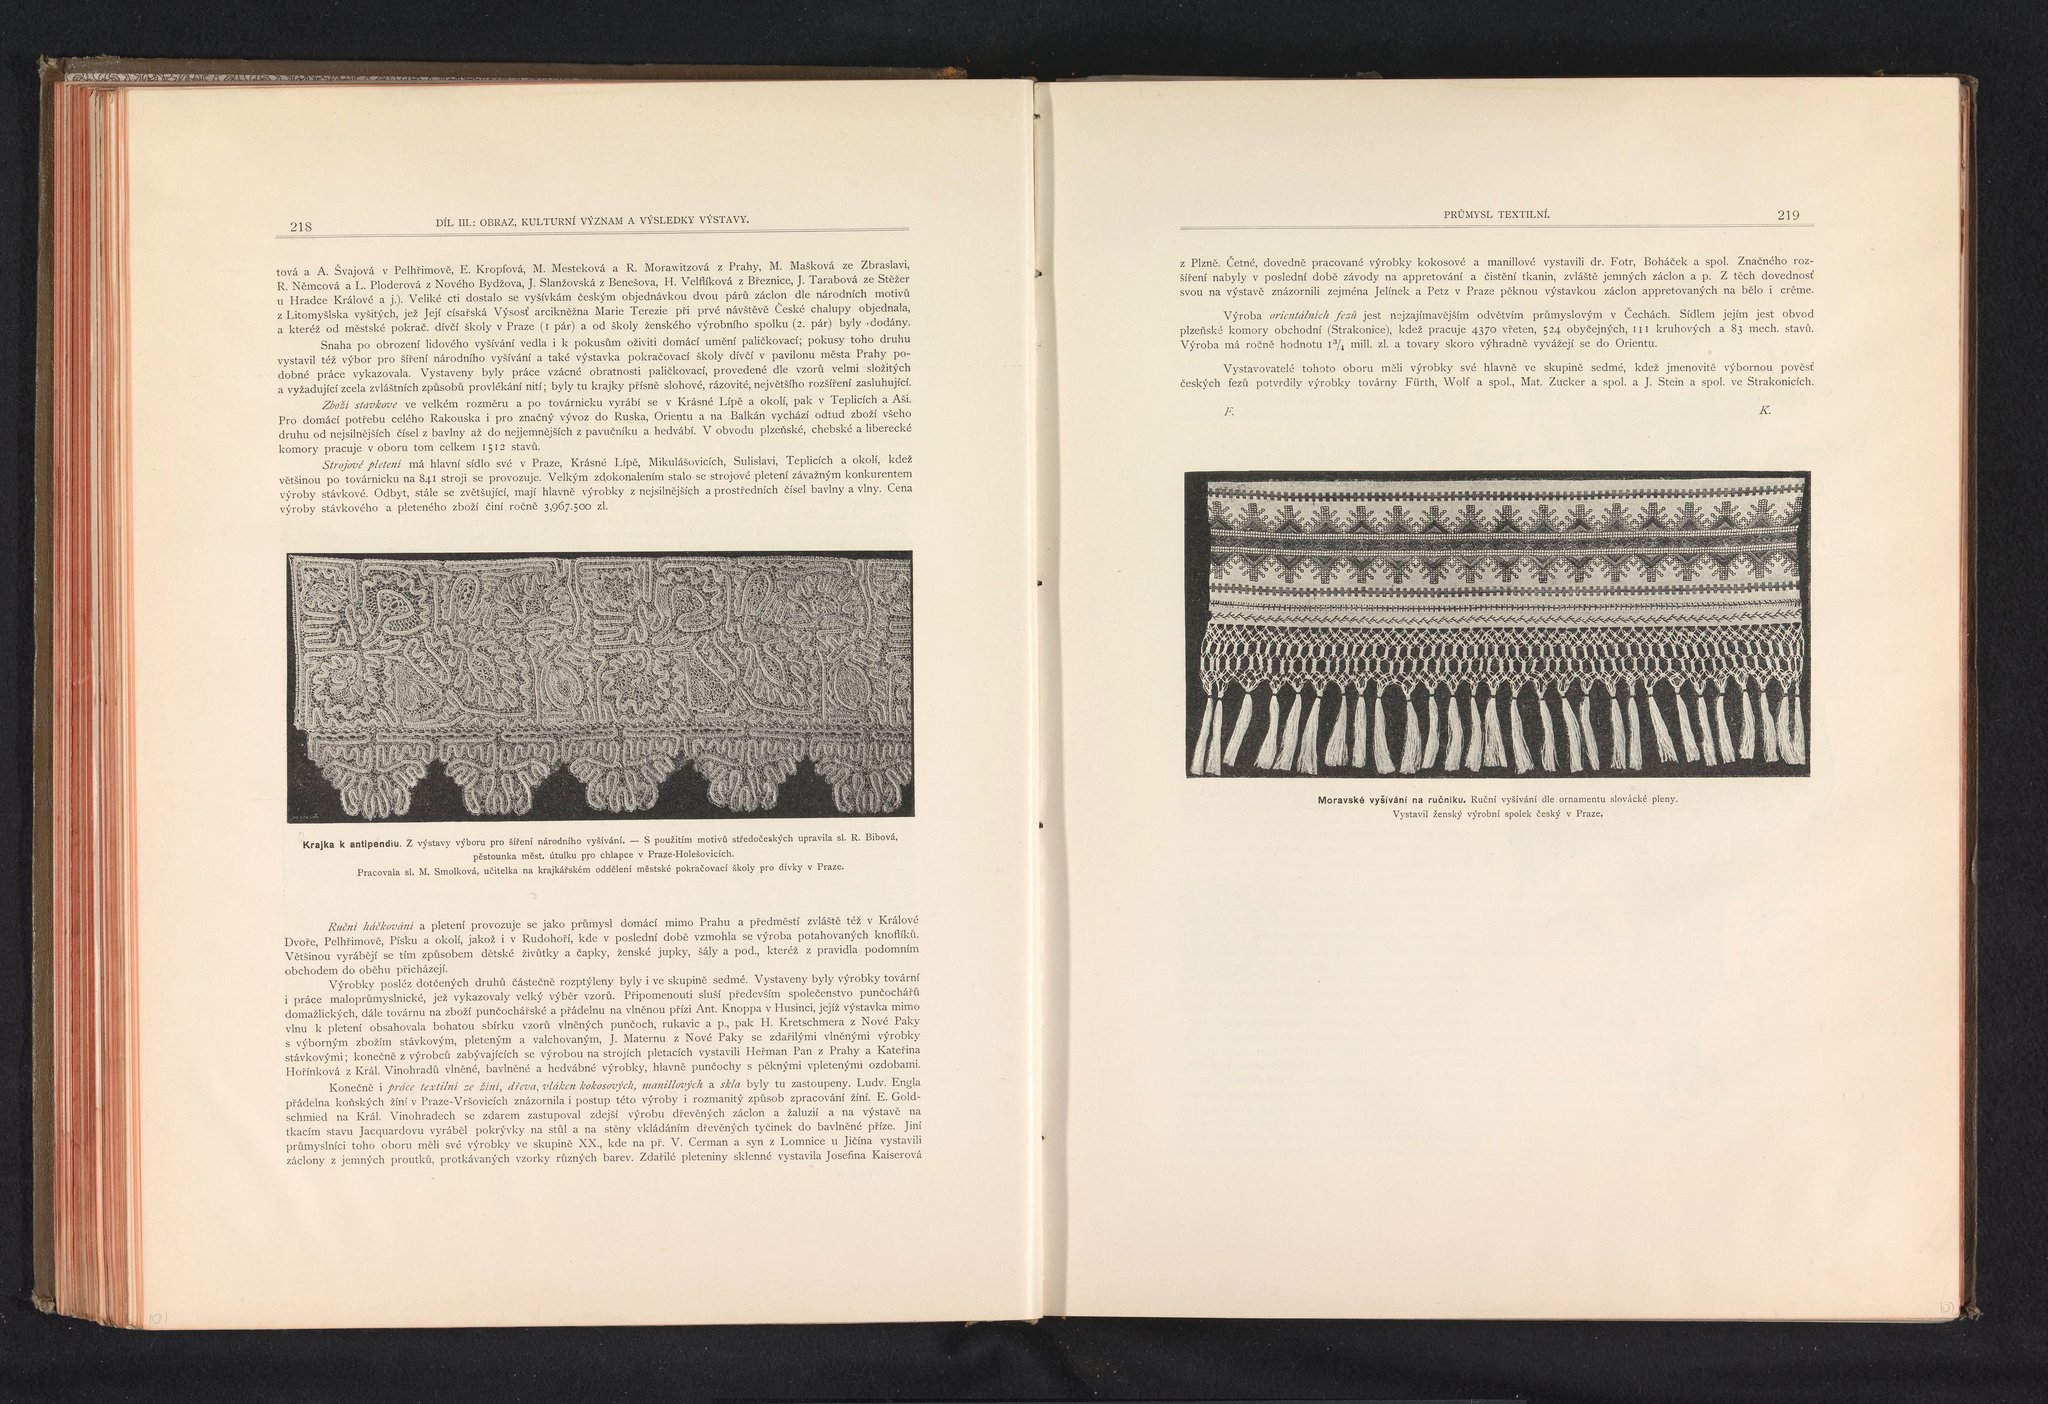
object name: photomechanical print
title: Krajka k antipendiu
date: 1890-1895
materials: paper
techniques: autotype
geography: prague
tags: 11q71422 antependium, frontal, lace